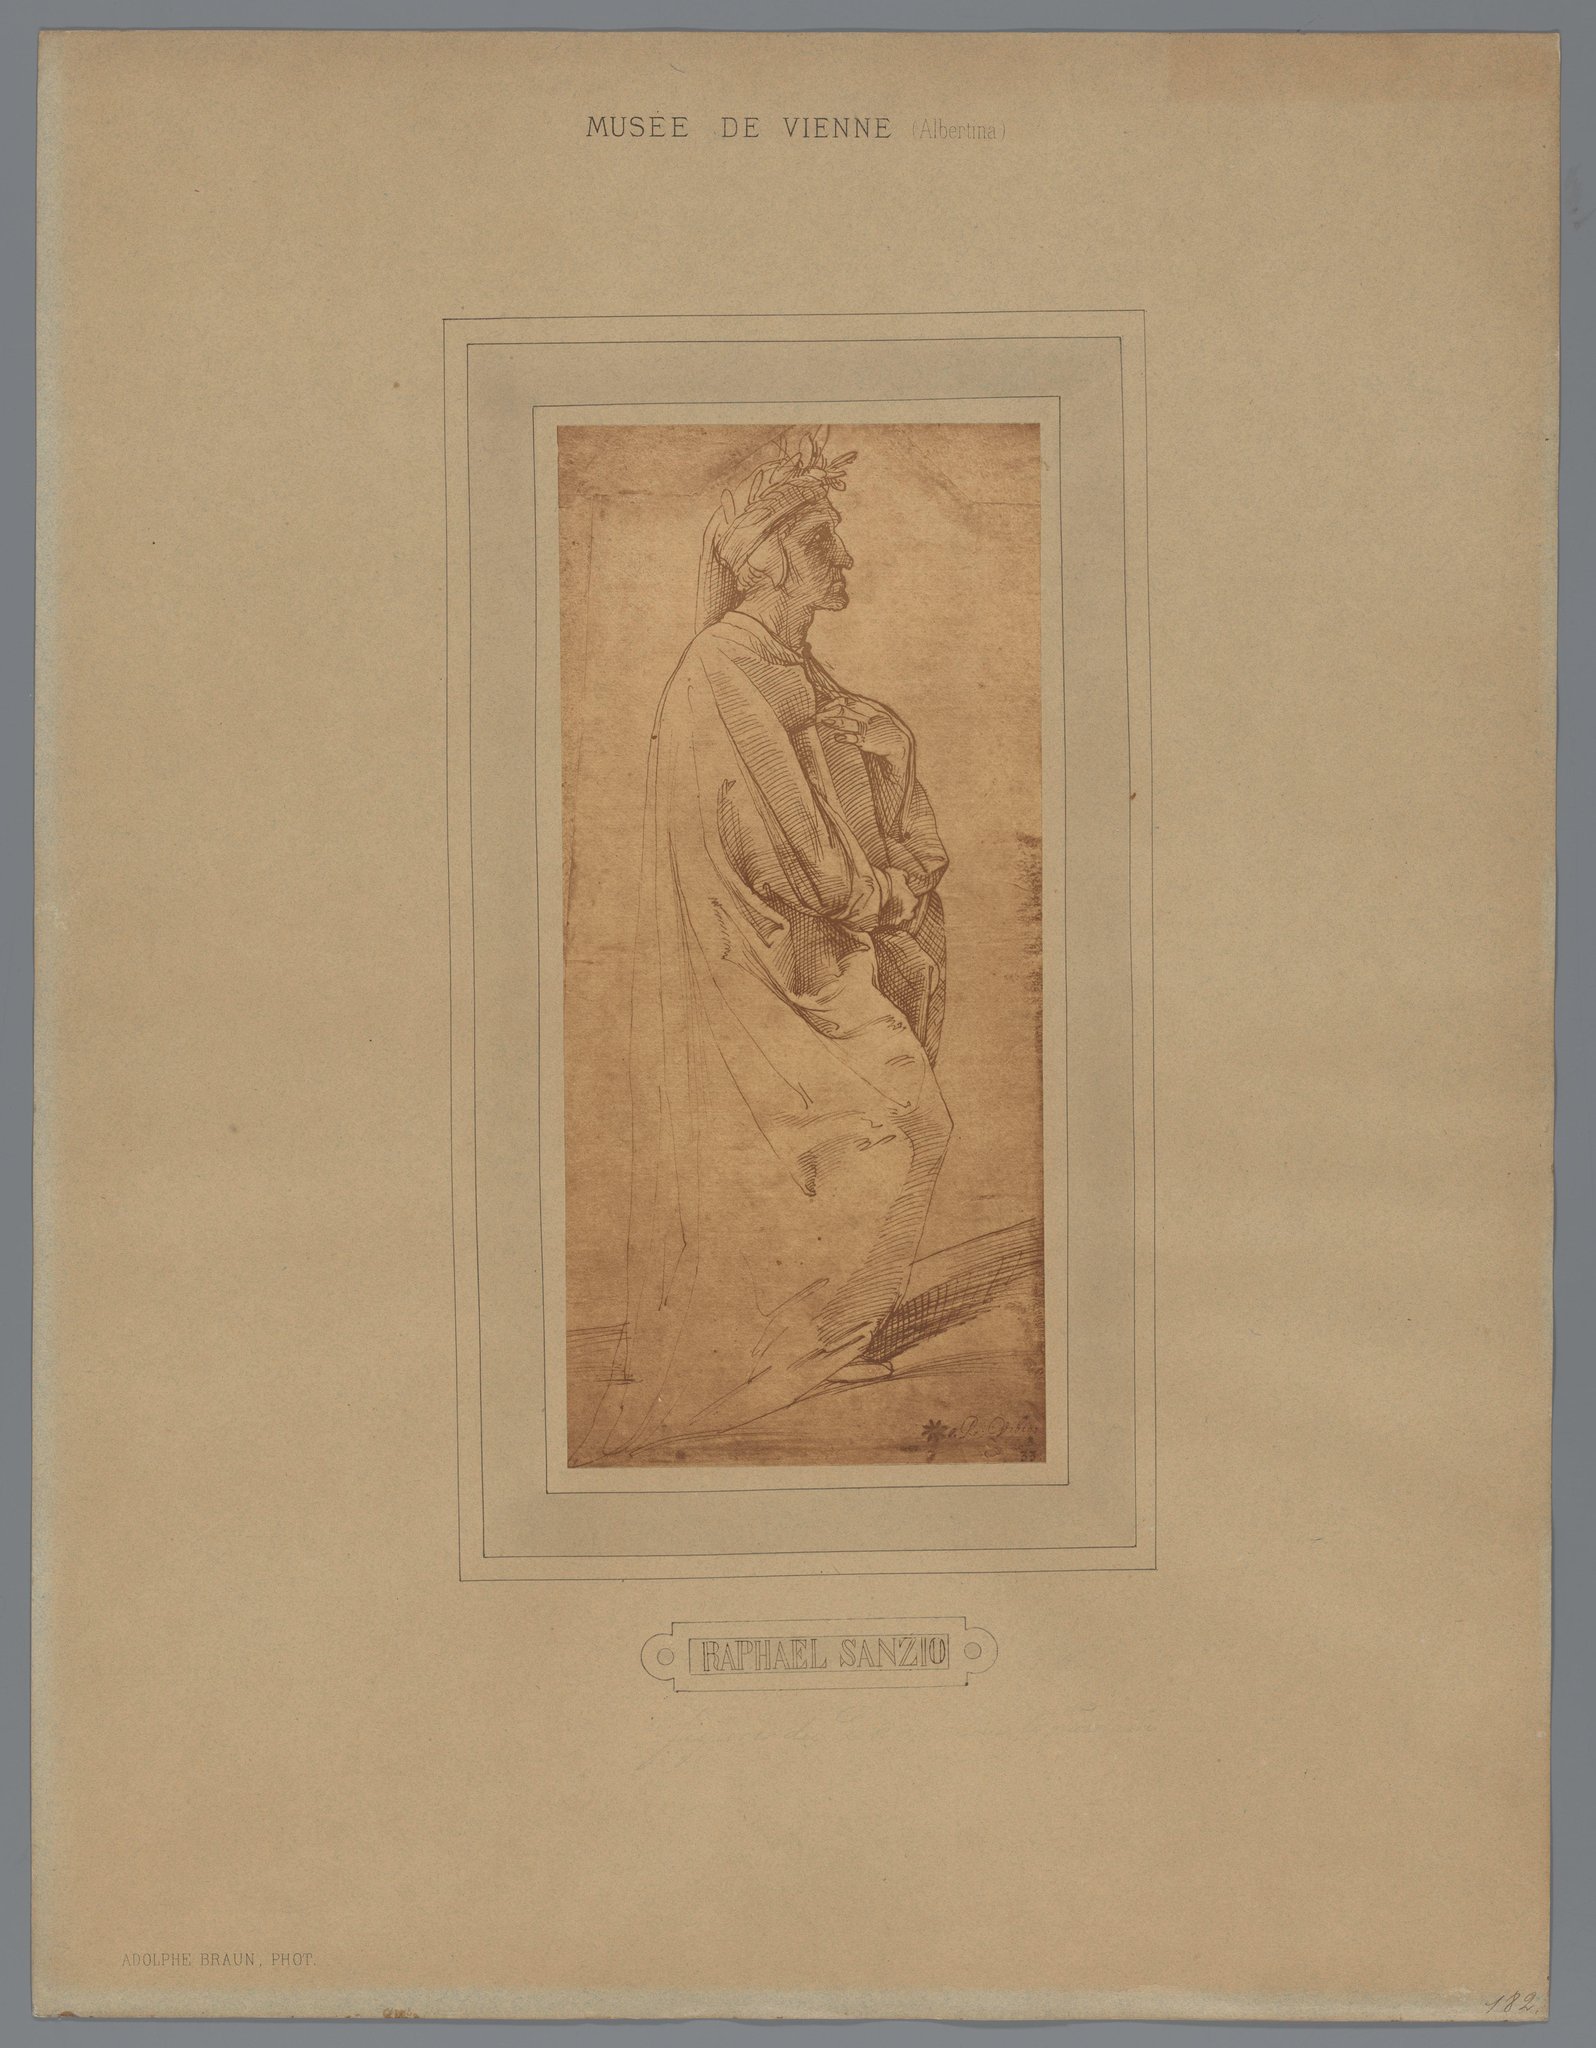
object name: photograph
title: Fotoreproductie van een tekening van Rafaël (Dante?)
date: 1880-1900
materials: cardboard, paper, photographic support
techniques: carbon print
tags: dante alighieri